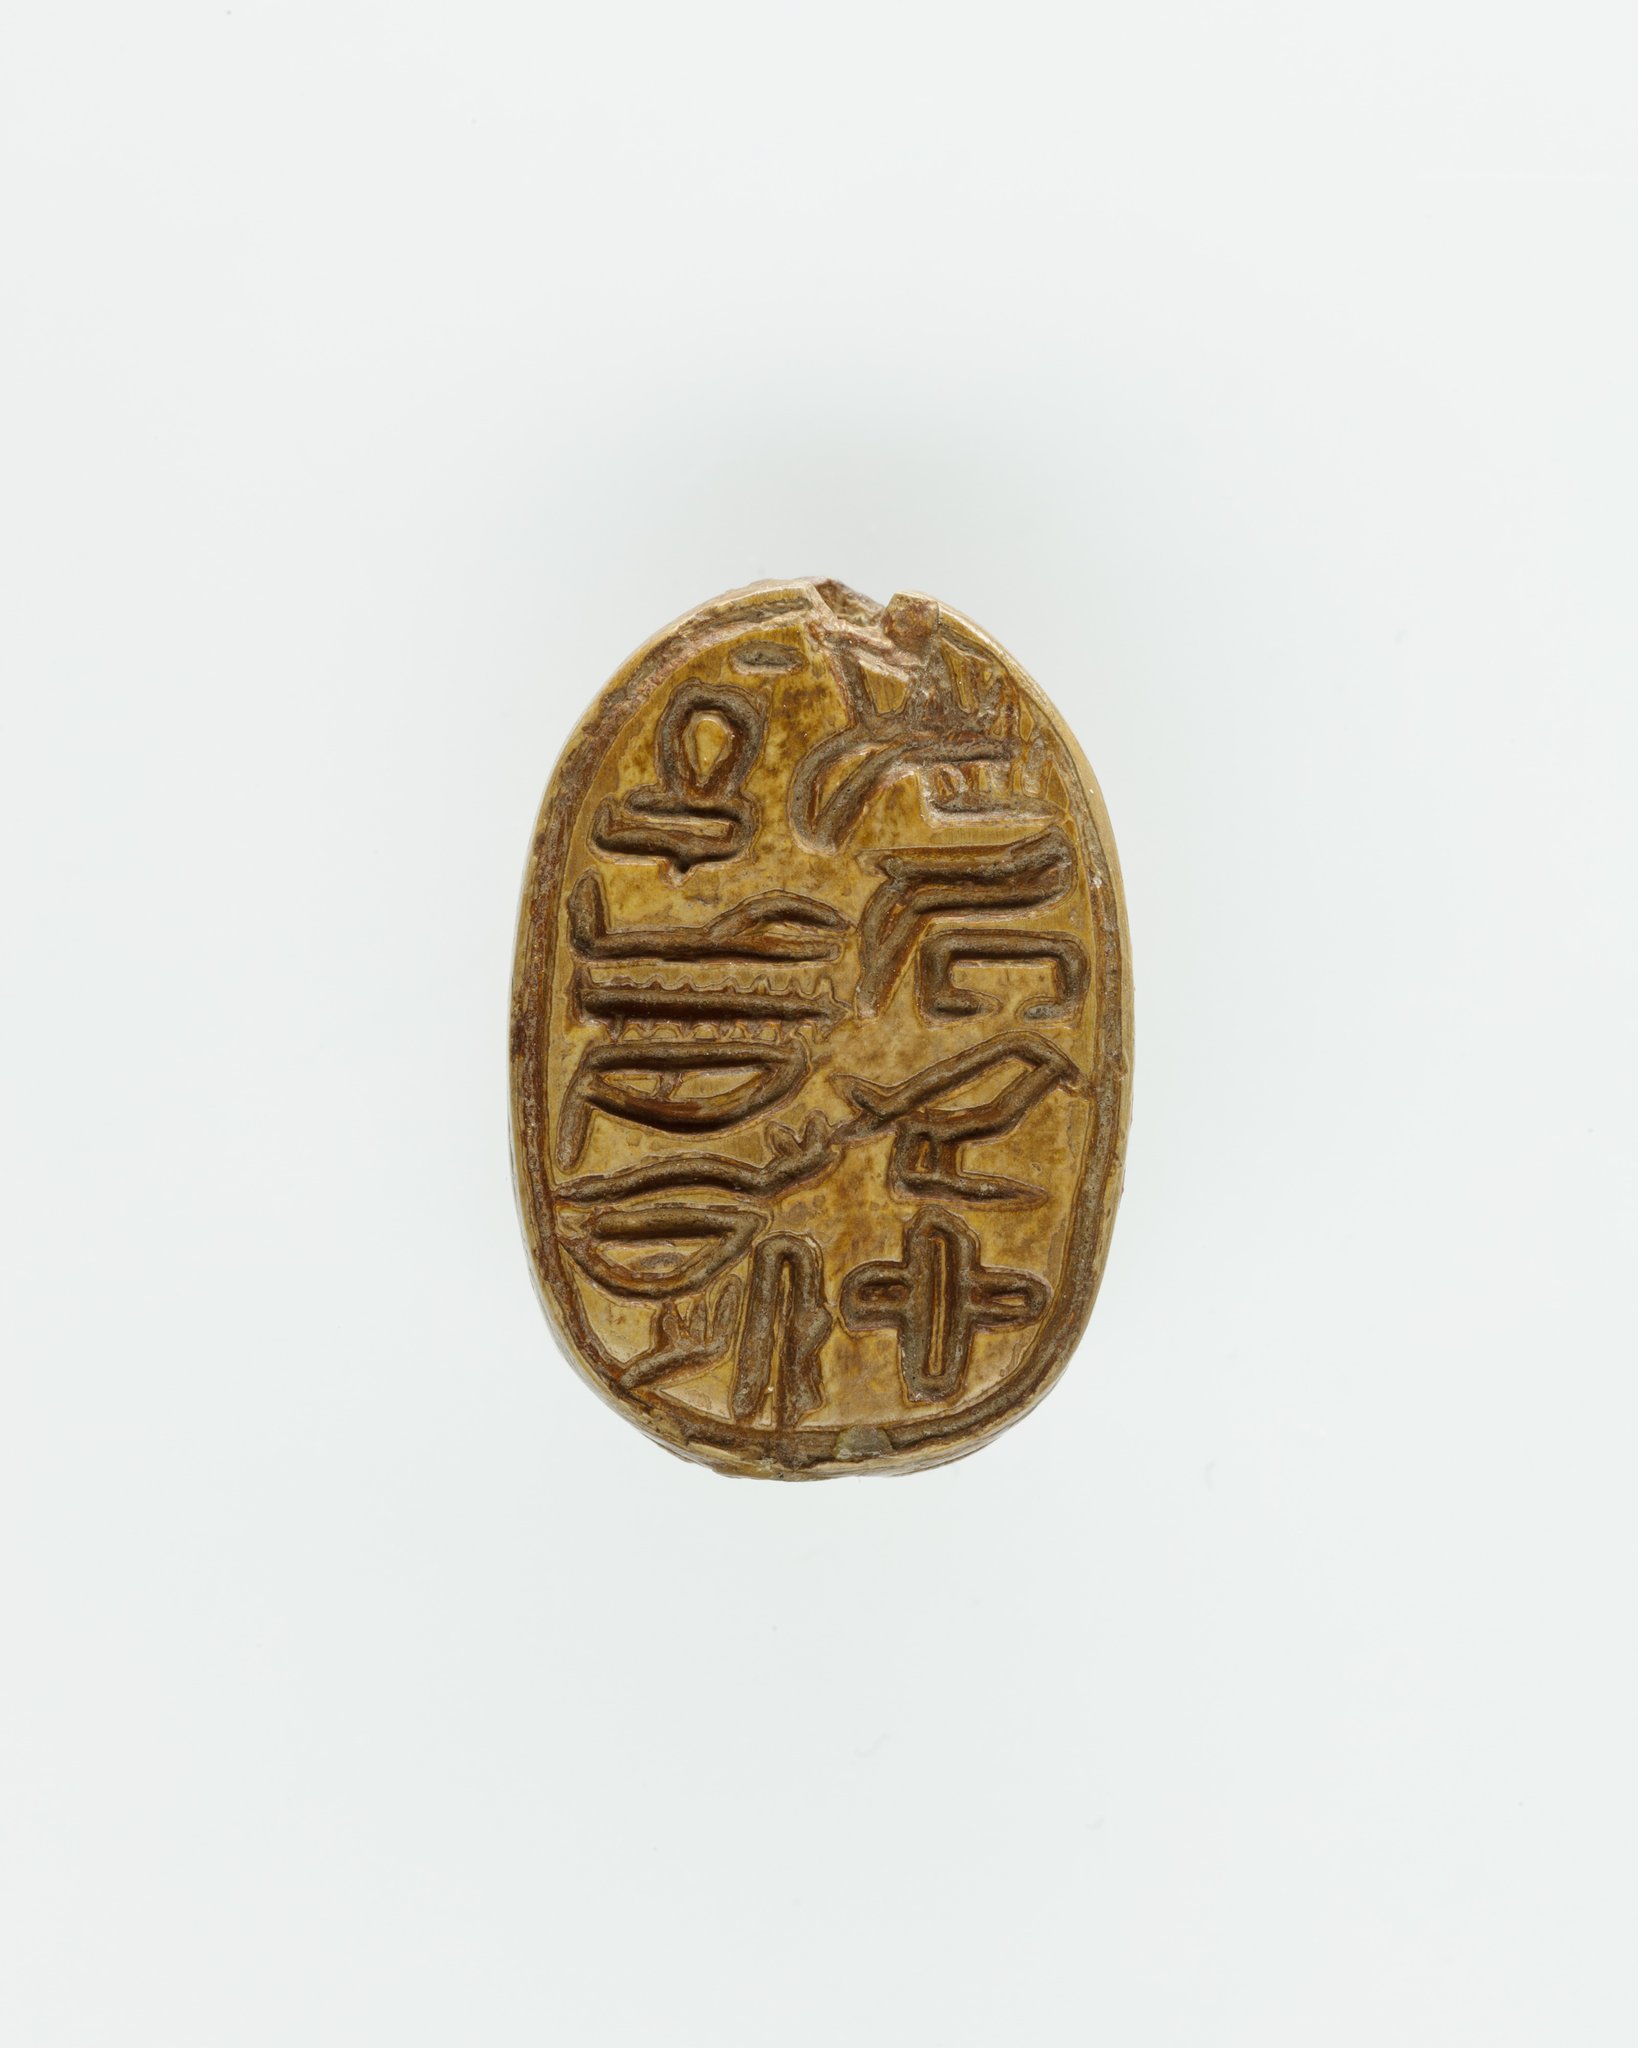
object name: scarab, private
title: Scarab Inscribed for an Official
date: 1760-1670 BCE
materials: stone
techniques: glazing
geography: egypt